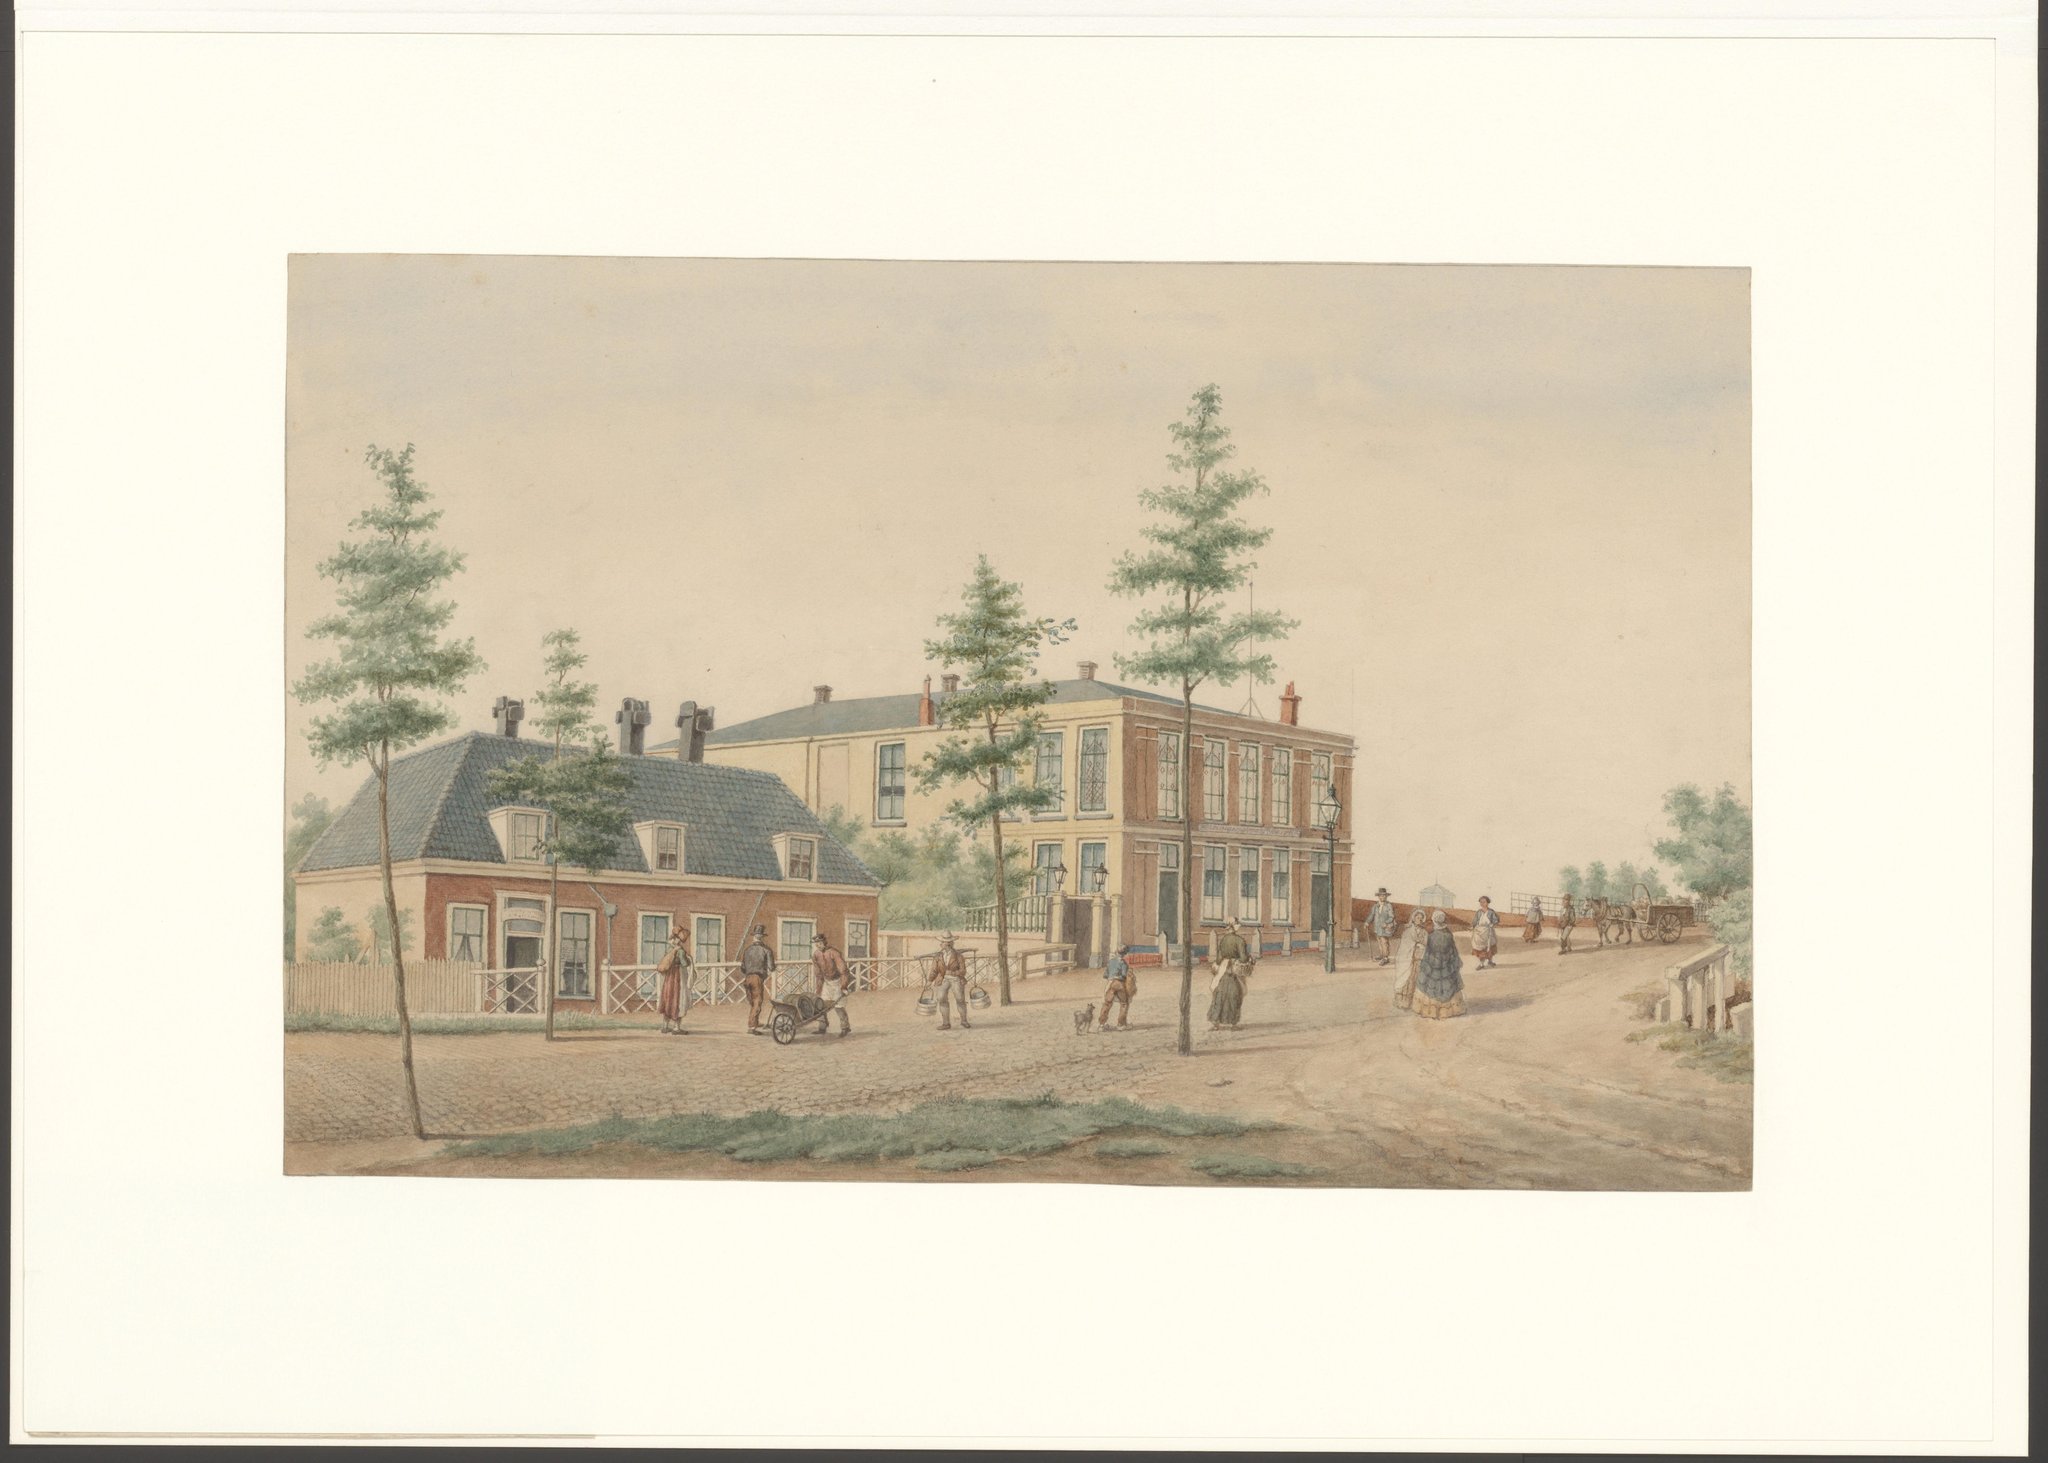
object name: drawing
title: Gezicht op sociëteit Apollo op de Schans bij de Hoge Sluis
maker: johan george lodewijk rieke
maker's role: draughtsman, print maker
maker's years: 1817-1898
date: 1861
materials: paper, pencil, watercolor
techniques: brush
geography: amsterdam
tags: city-view in general; 'veduta', road, path, façade (of house or building)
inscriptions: inscription: ‘Apolo in gebruik (...) JGL Rieke 1861.’, inscription: ‘Port. 12 - 294’, collector's mark: ‘12’ Lugt 1641b, inscription: ‘Atlas D.C. Meijer (...) Genootschap / te Amsterdam’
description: Onderwerpsrubriek binnen de Atlas Amsterdam: Sarphatistraat, Schans.